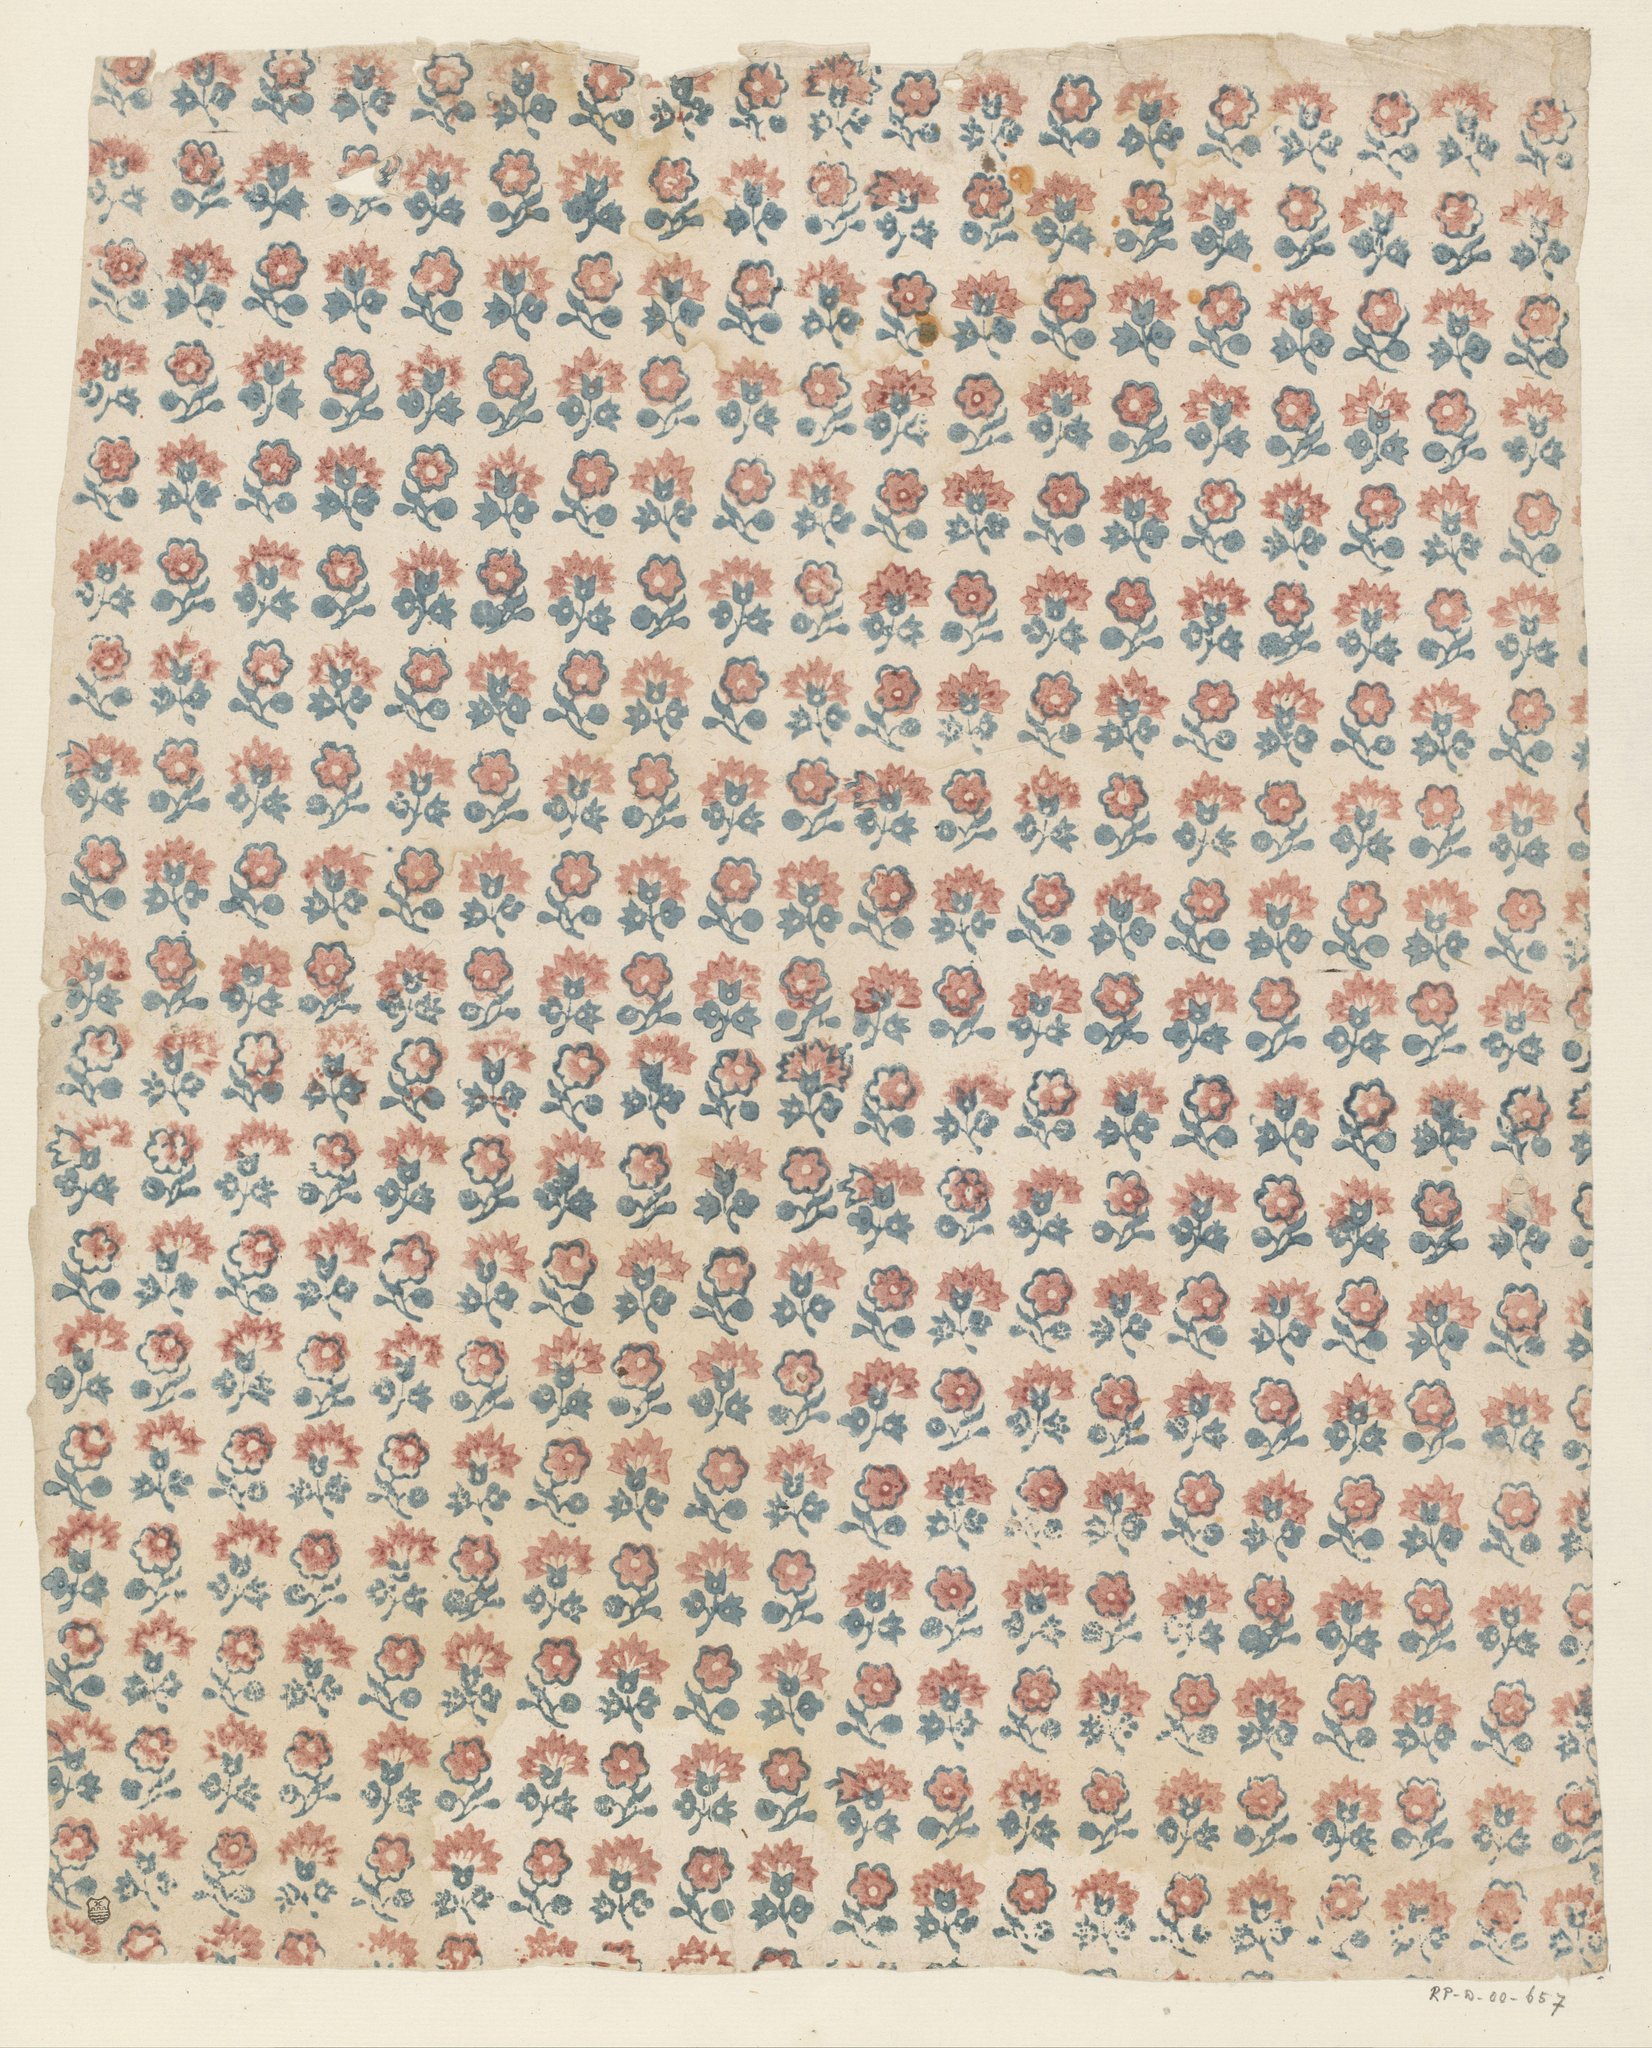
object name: printed paper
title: Blad met strooipatroon van bloemen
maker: Anonymous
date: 1750-1900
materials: paper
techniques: printing block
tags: ornament derived from plant forms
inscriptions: collector's mark: Lugt 2760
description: Blad met alternerend strooipatroon van twee soorten bloemen.